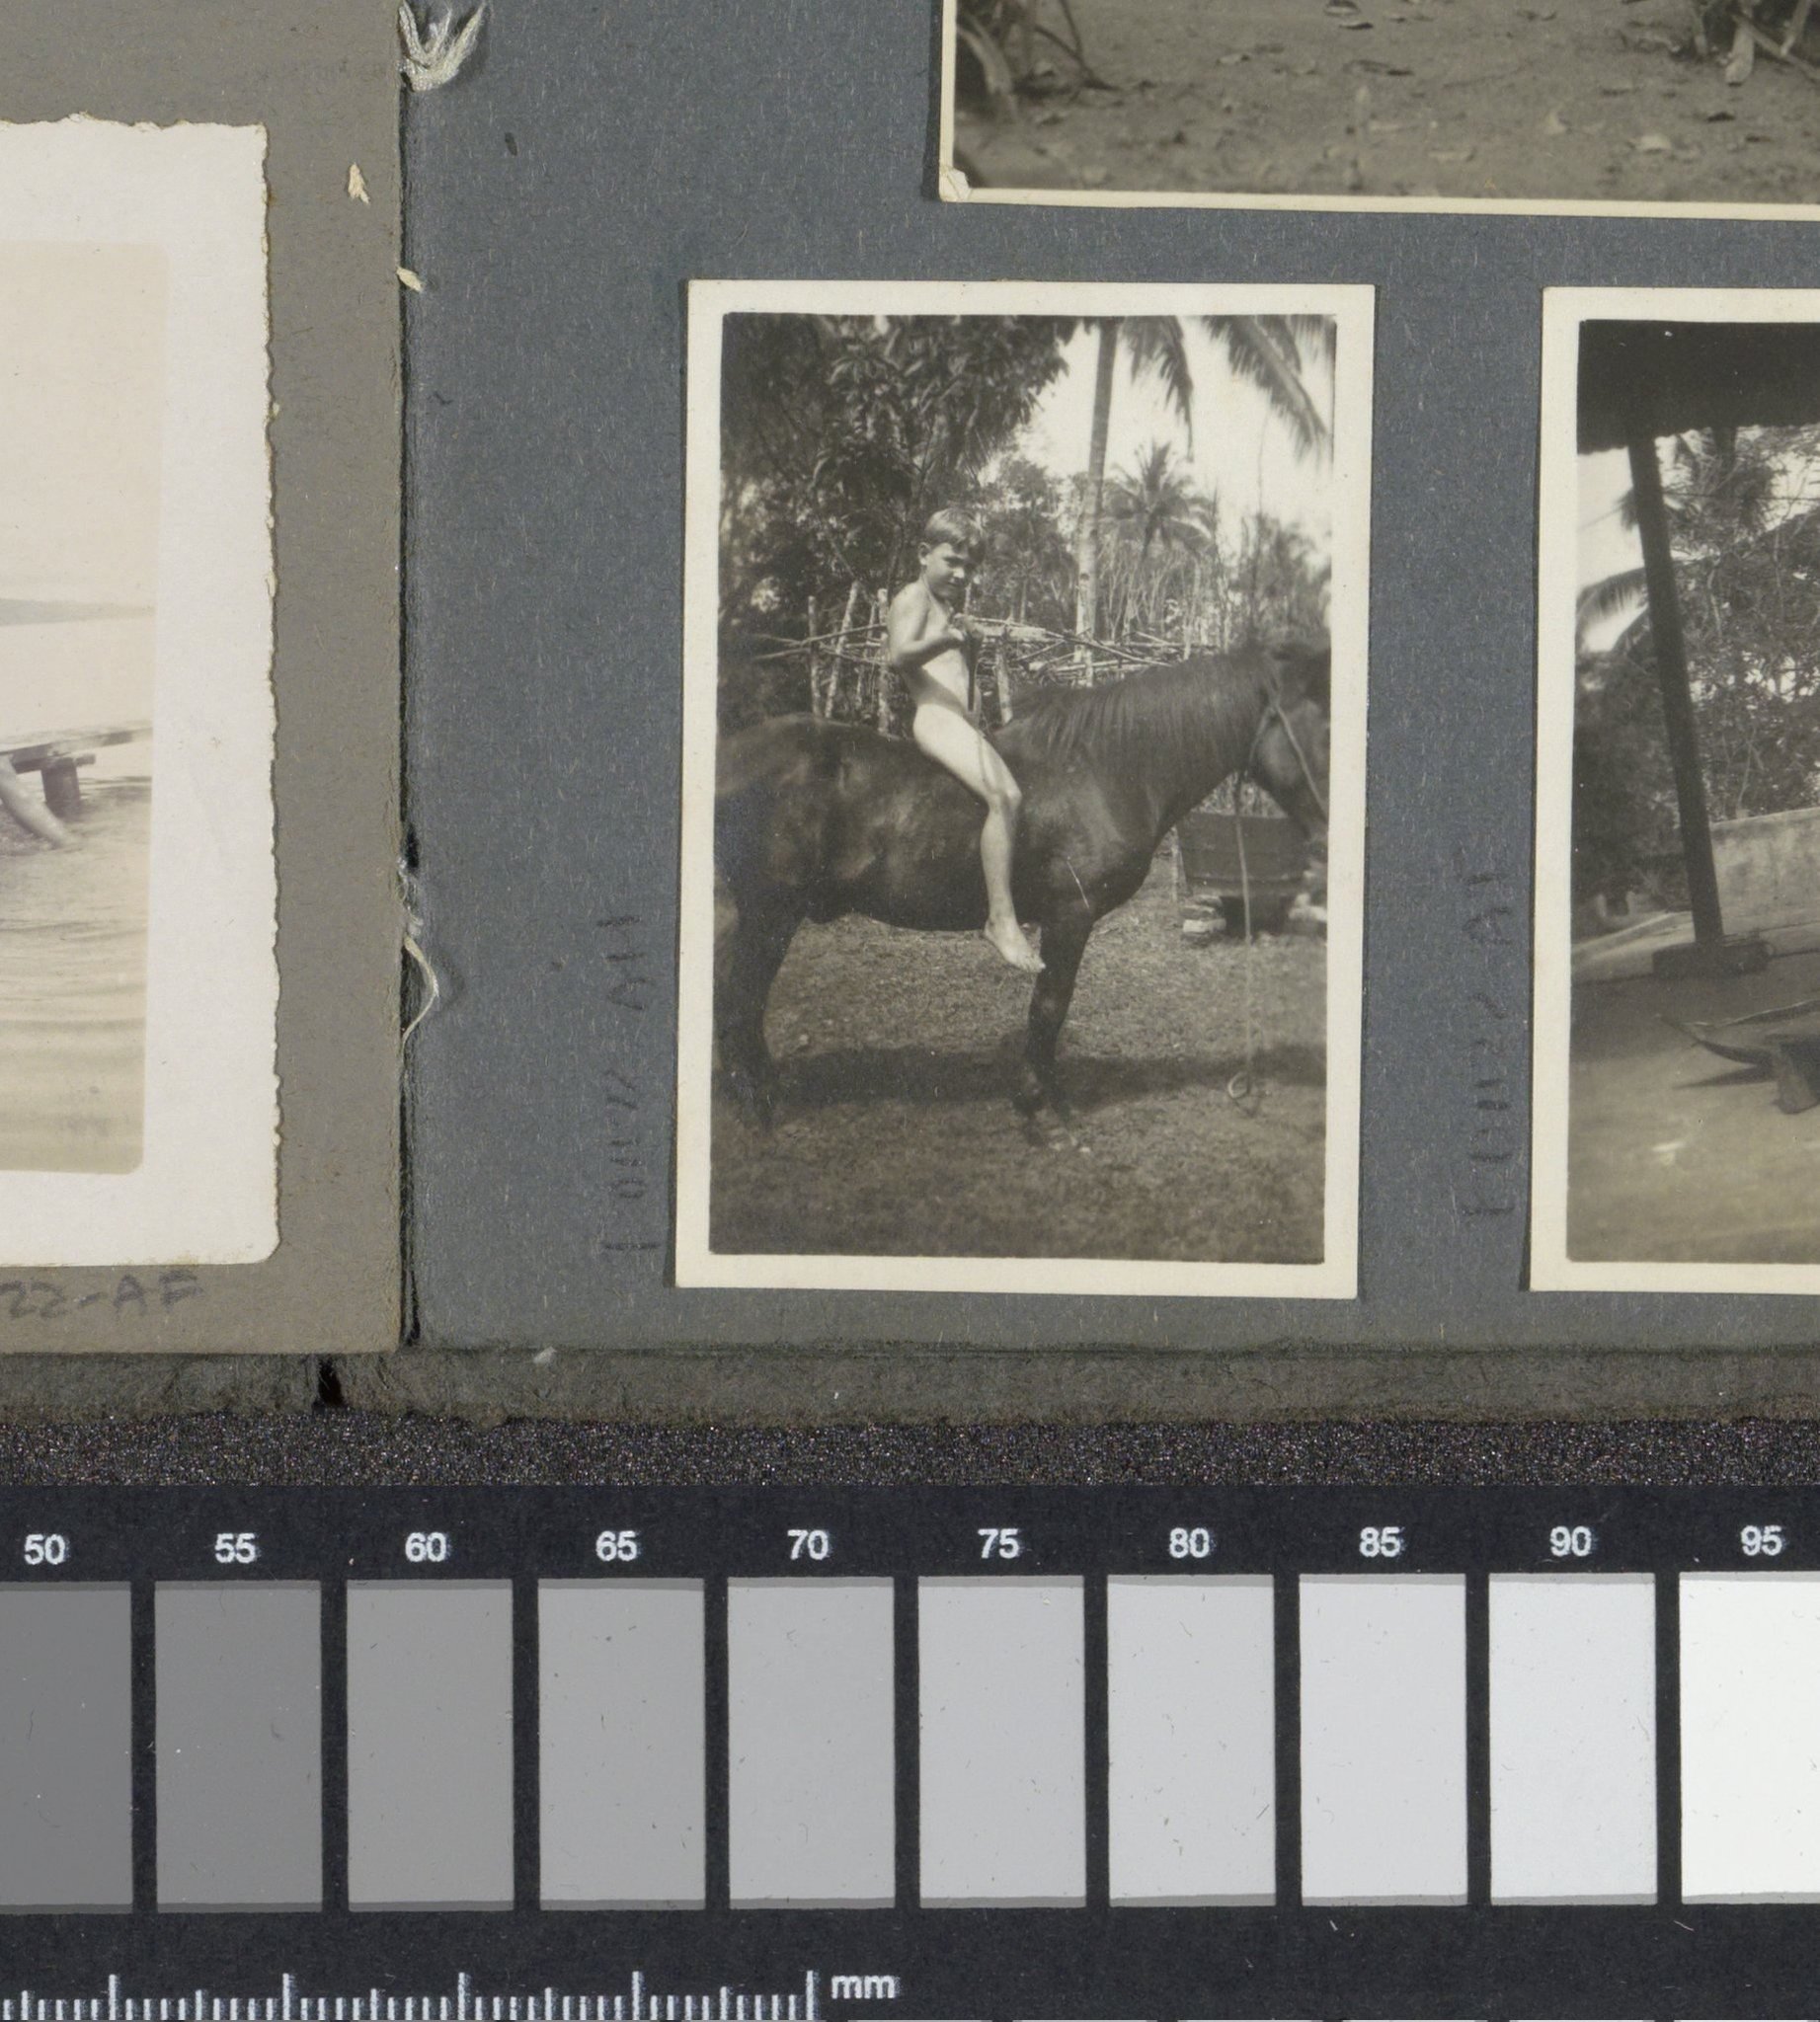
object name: photograph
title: Naakte jongen te paard op Sumatra, vermoedelijk kind van de familie Bergsma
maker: Anonymous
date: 1914-1926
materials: photographic support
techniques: gelatin silver print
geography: sumatra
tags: riding a horse, ass, or mule; rider, horseman, child, sumatra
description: Onderdeel van fotoalbum met opnames van de familie Bergsma in Tandjong Poera en Rantan Pandjang (Sumatra).